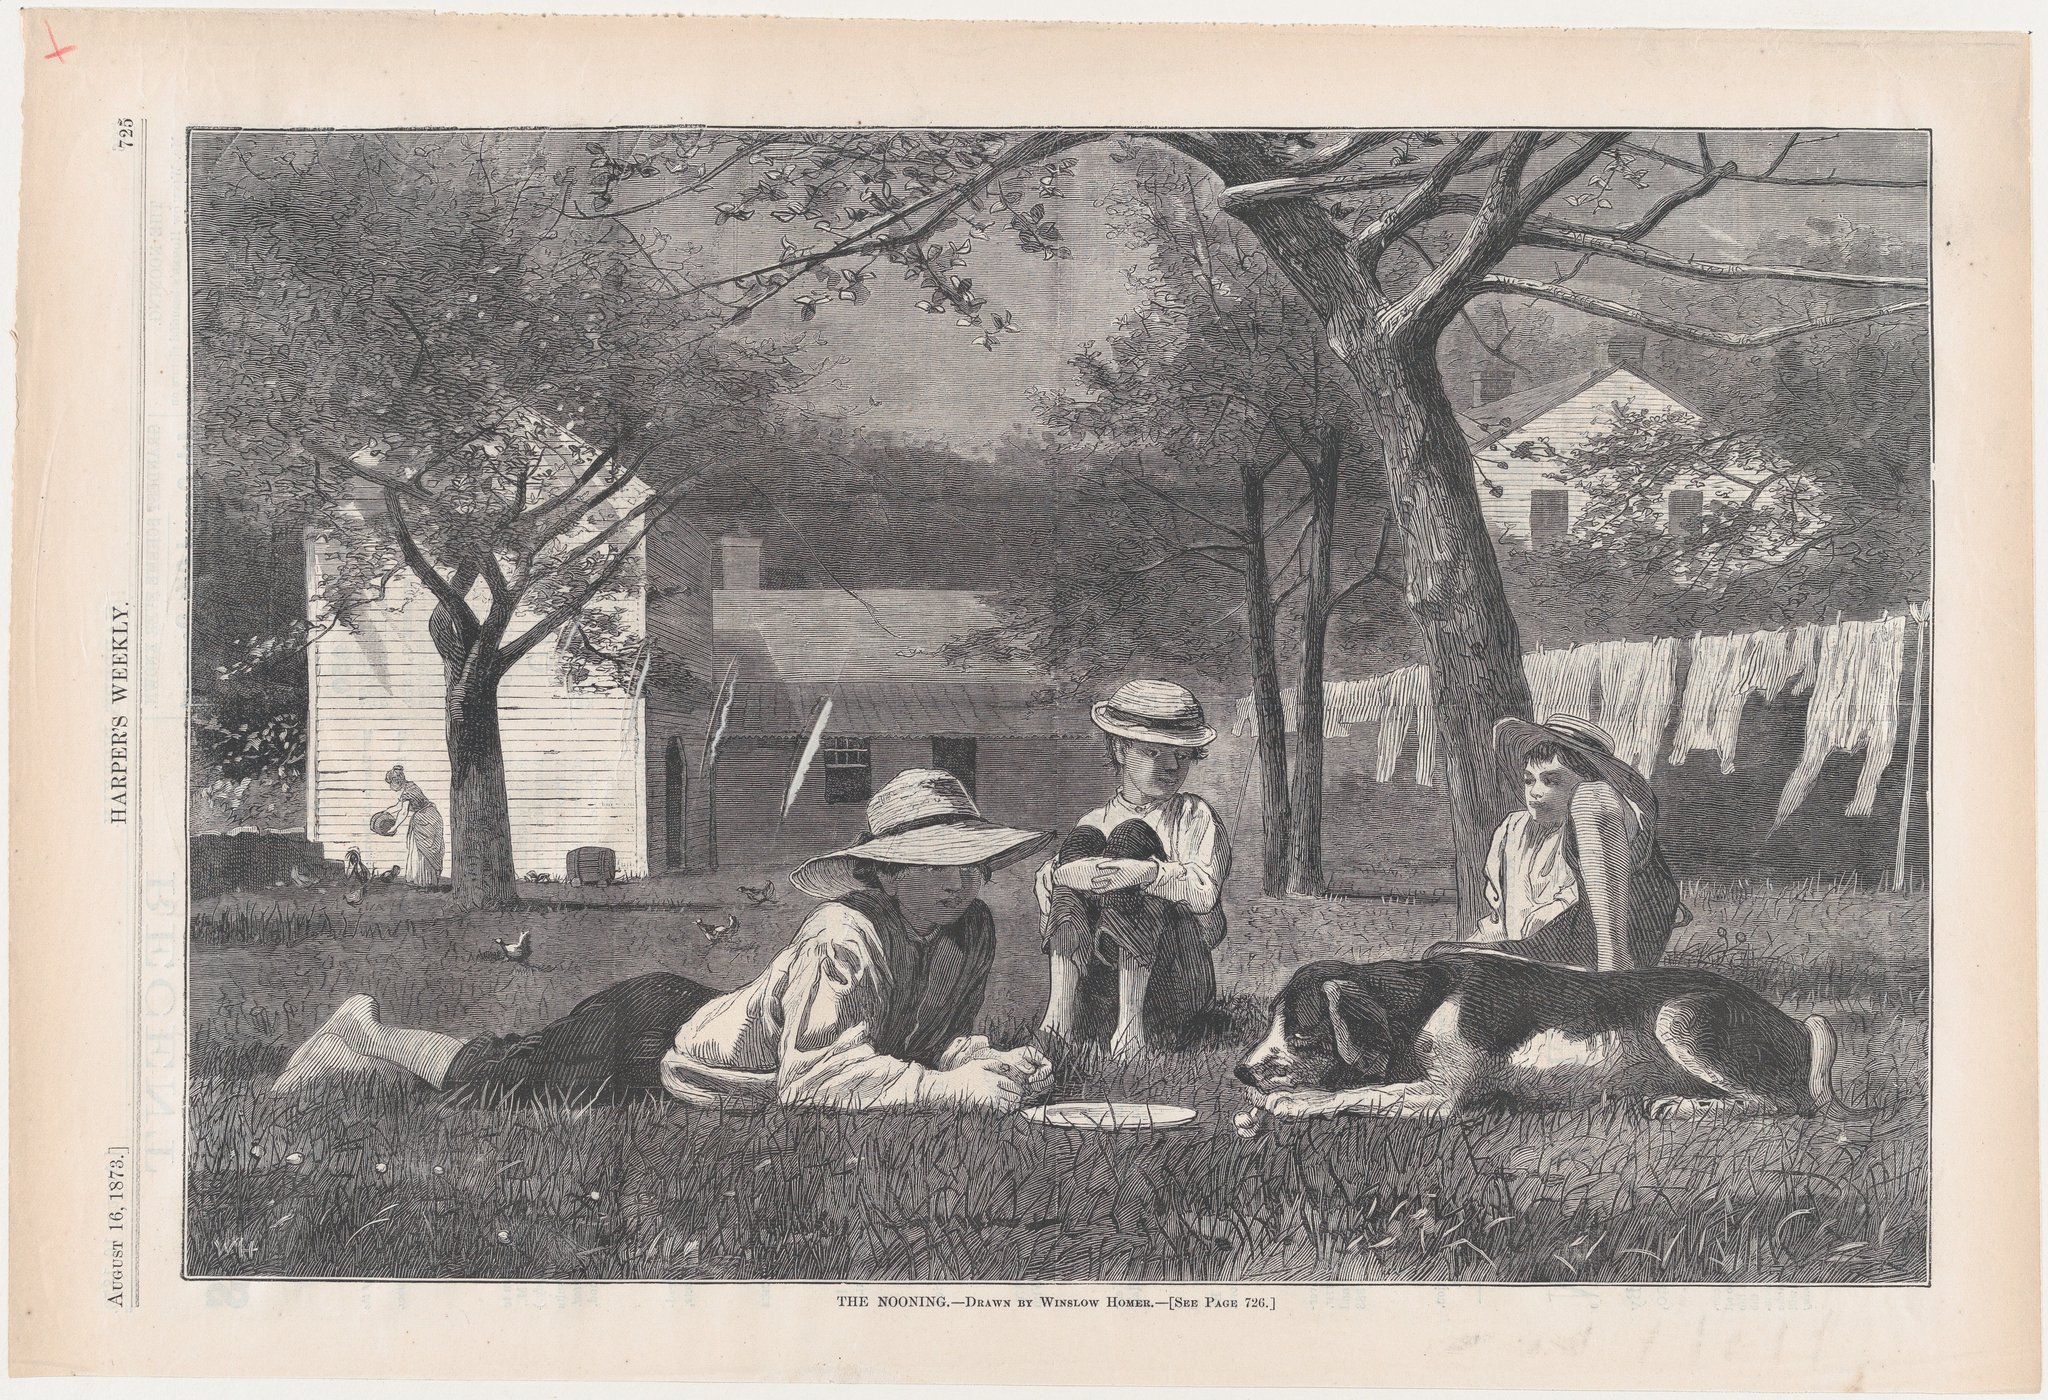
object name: print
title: The Nooning (from "Harper's Weekly," Vol. XVII)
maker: winslow homer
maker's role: artist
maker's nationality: american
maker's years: 1836-1910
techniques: engraving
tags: chickens,houses,boys,dogs